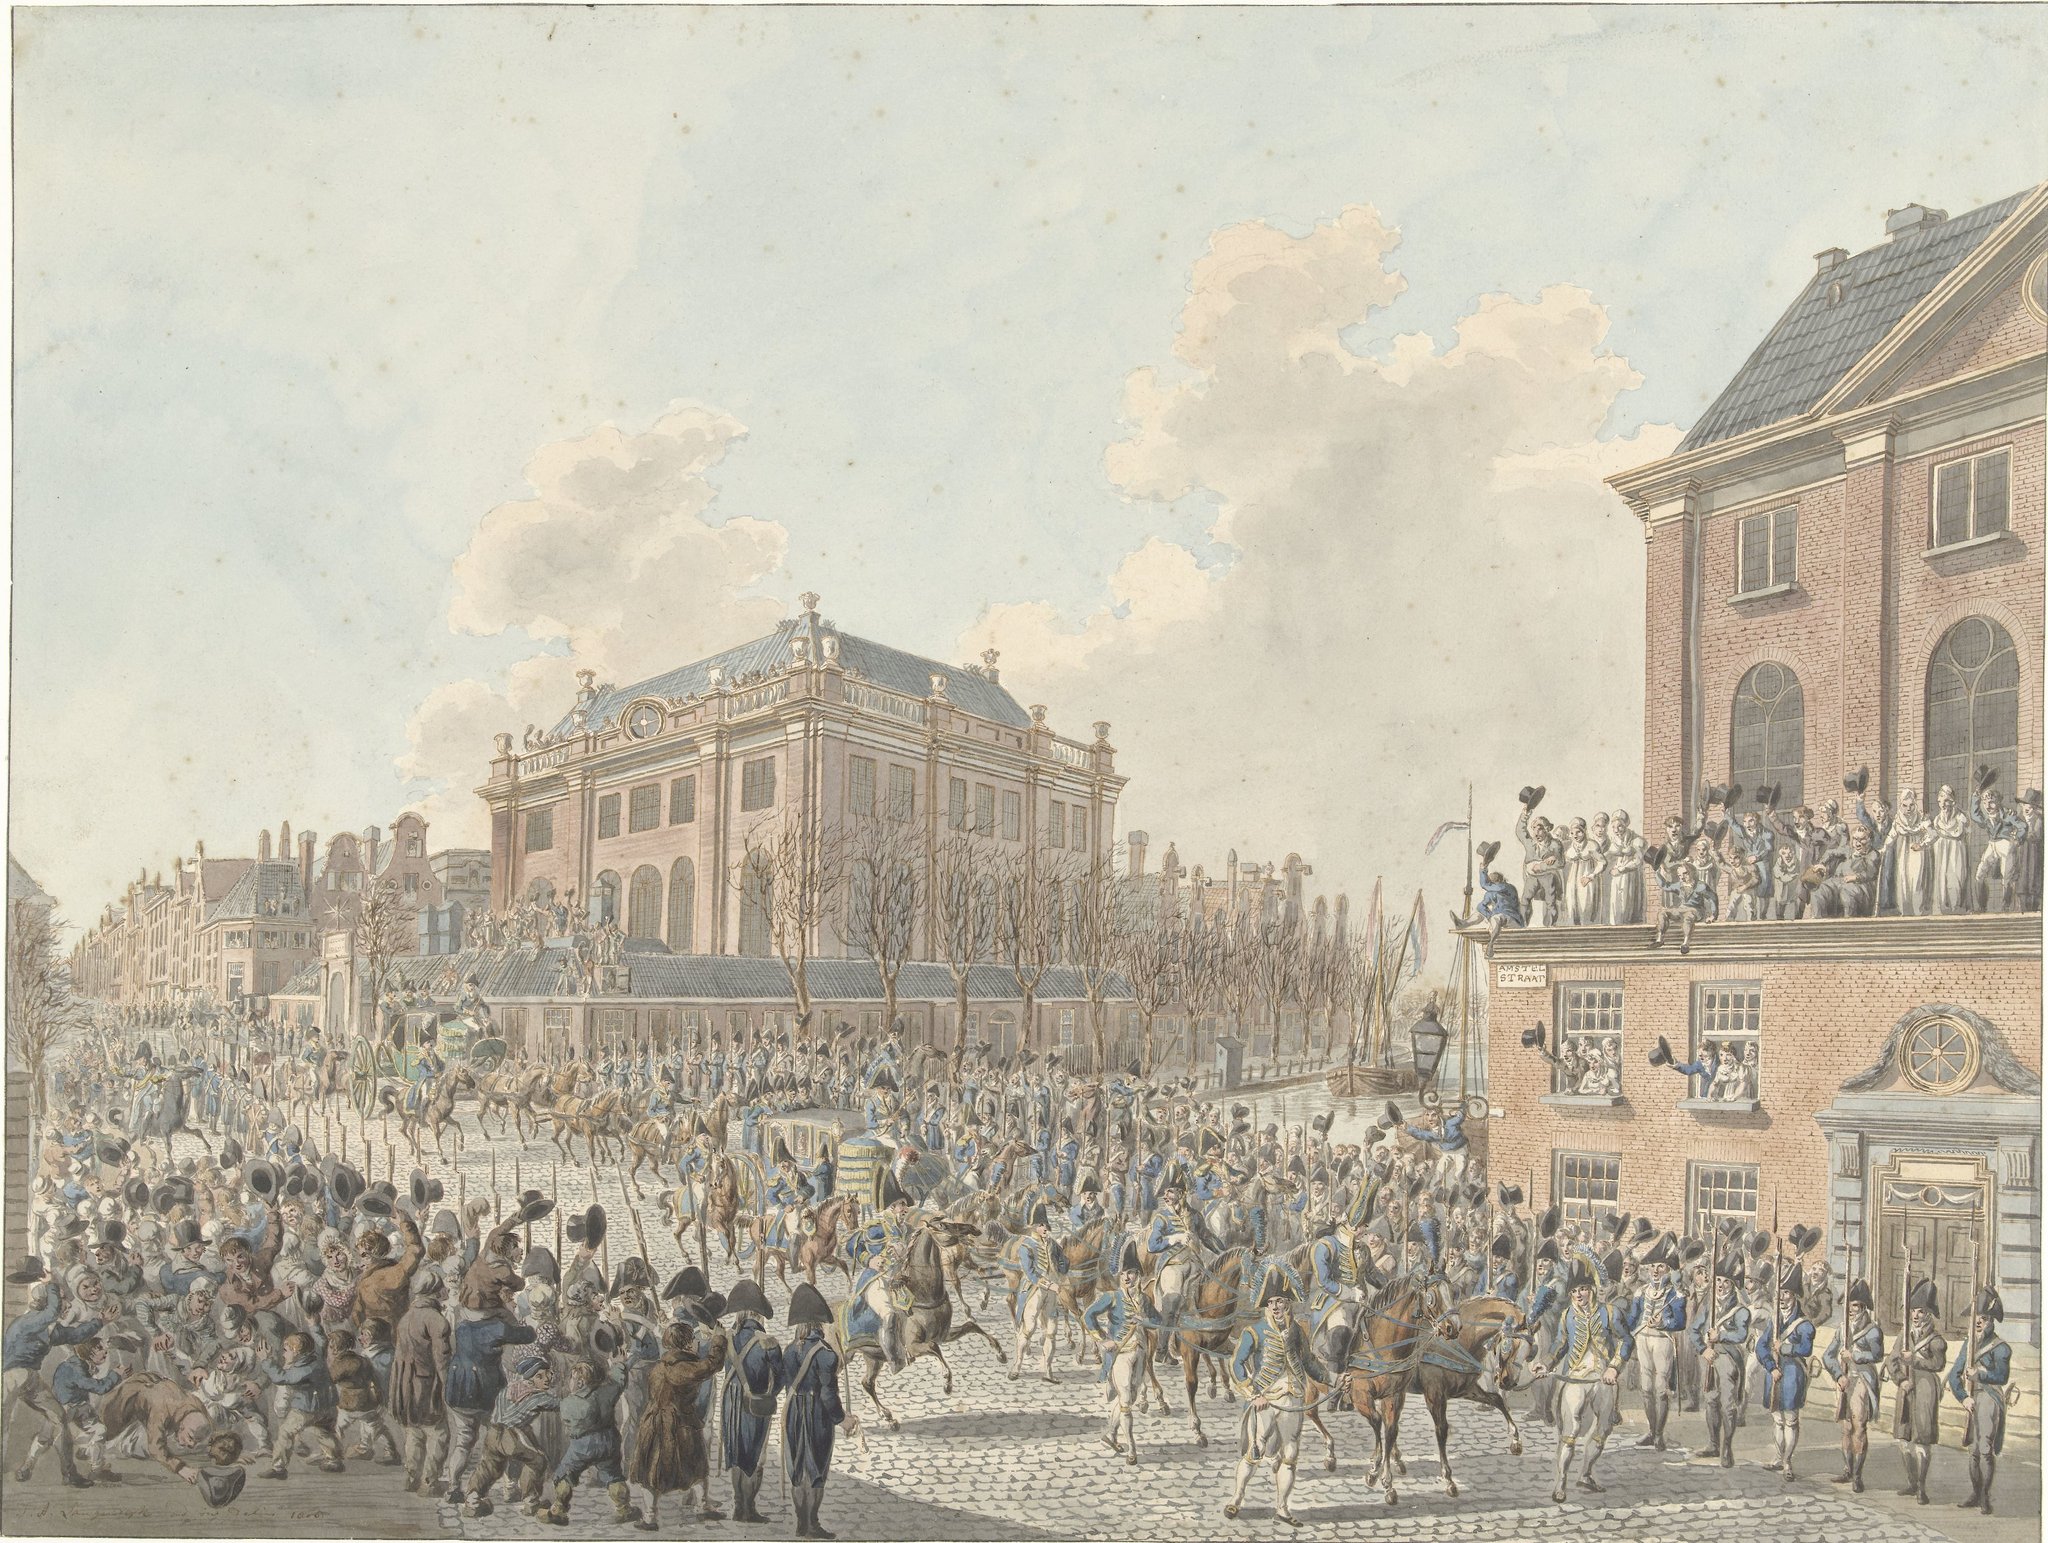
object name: drawing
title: De inkomst te Amsterdam van Lodewijk Napoleon op 20 April 1808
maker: jan anthonie langendijk dzn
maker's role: draughtsman, print maker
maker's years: 1780-1818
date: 1808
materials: paper, pencil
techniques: brush, pen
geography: netherlands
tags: louis napoleon (king of holland), public festivities at other royal events, not meant or mentioned above, triumphal entry and public reception, pageant, 'entrée solennelle', 'joyeuse entrée', festivities on events of national importance, installation of a ruler, amsterdam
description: Feestelijke inkomst van Lodewijk Napoleon als koning van Holland te Amsterdam, 20 april 1808. Optocht van twee koetsen met escorte, op straat veel juichende toeschouwers. Gezien vanuit de Nieuwe Amstelstraat. Rechts de Portugees-Israëlitische Synagoge (thans Mr. Visserplein), rechts vooraan de Grote Synagoge (Nieuwe Amstelstraat).